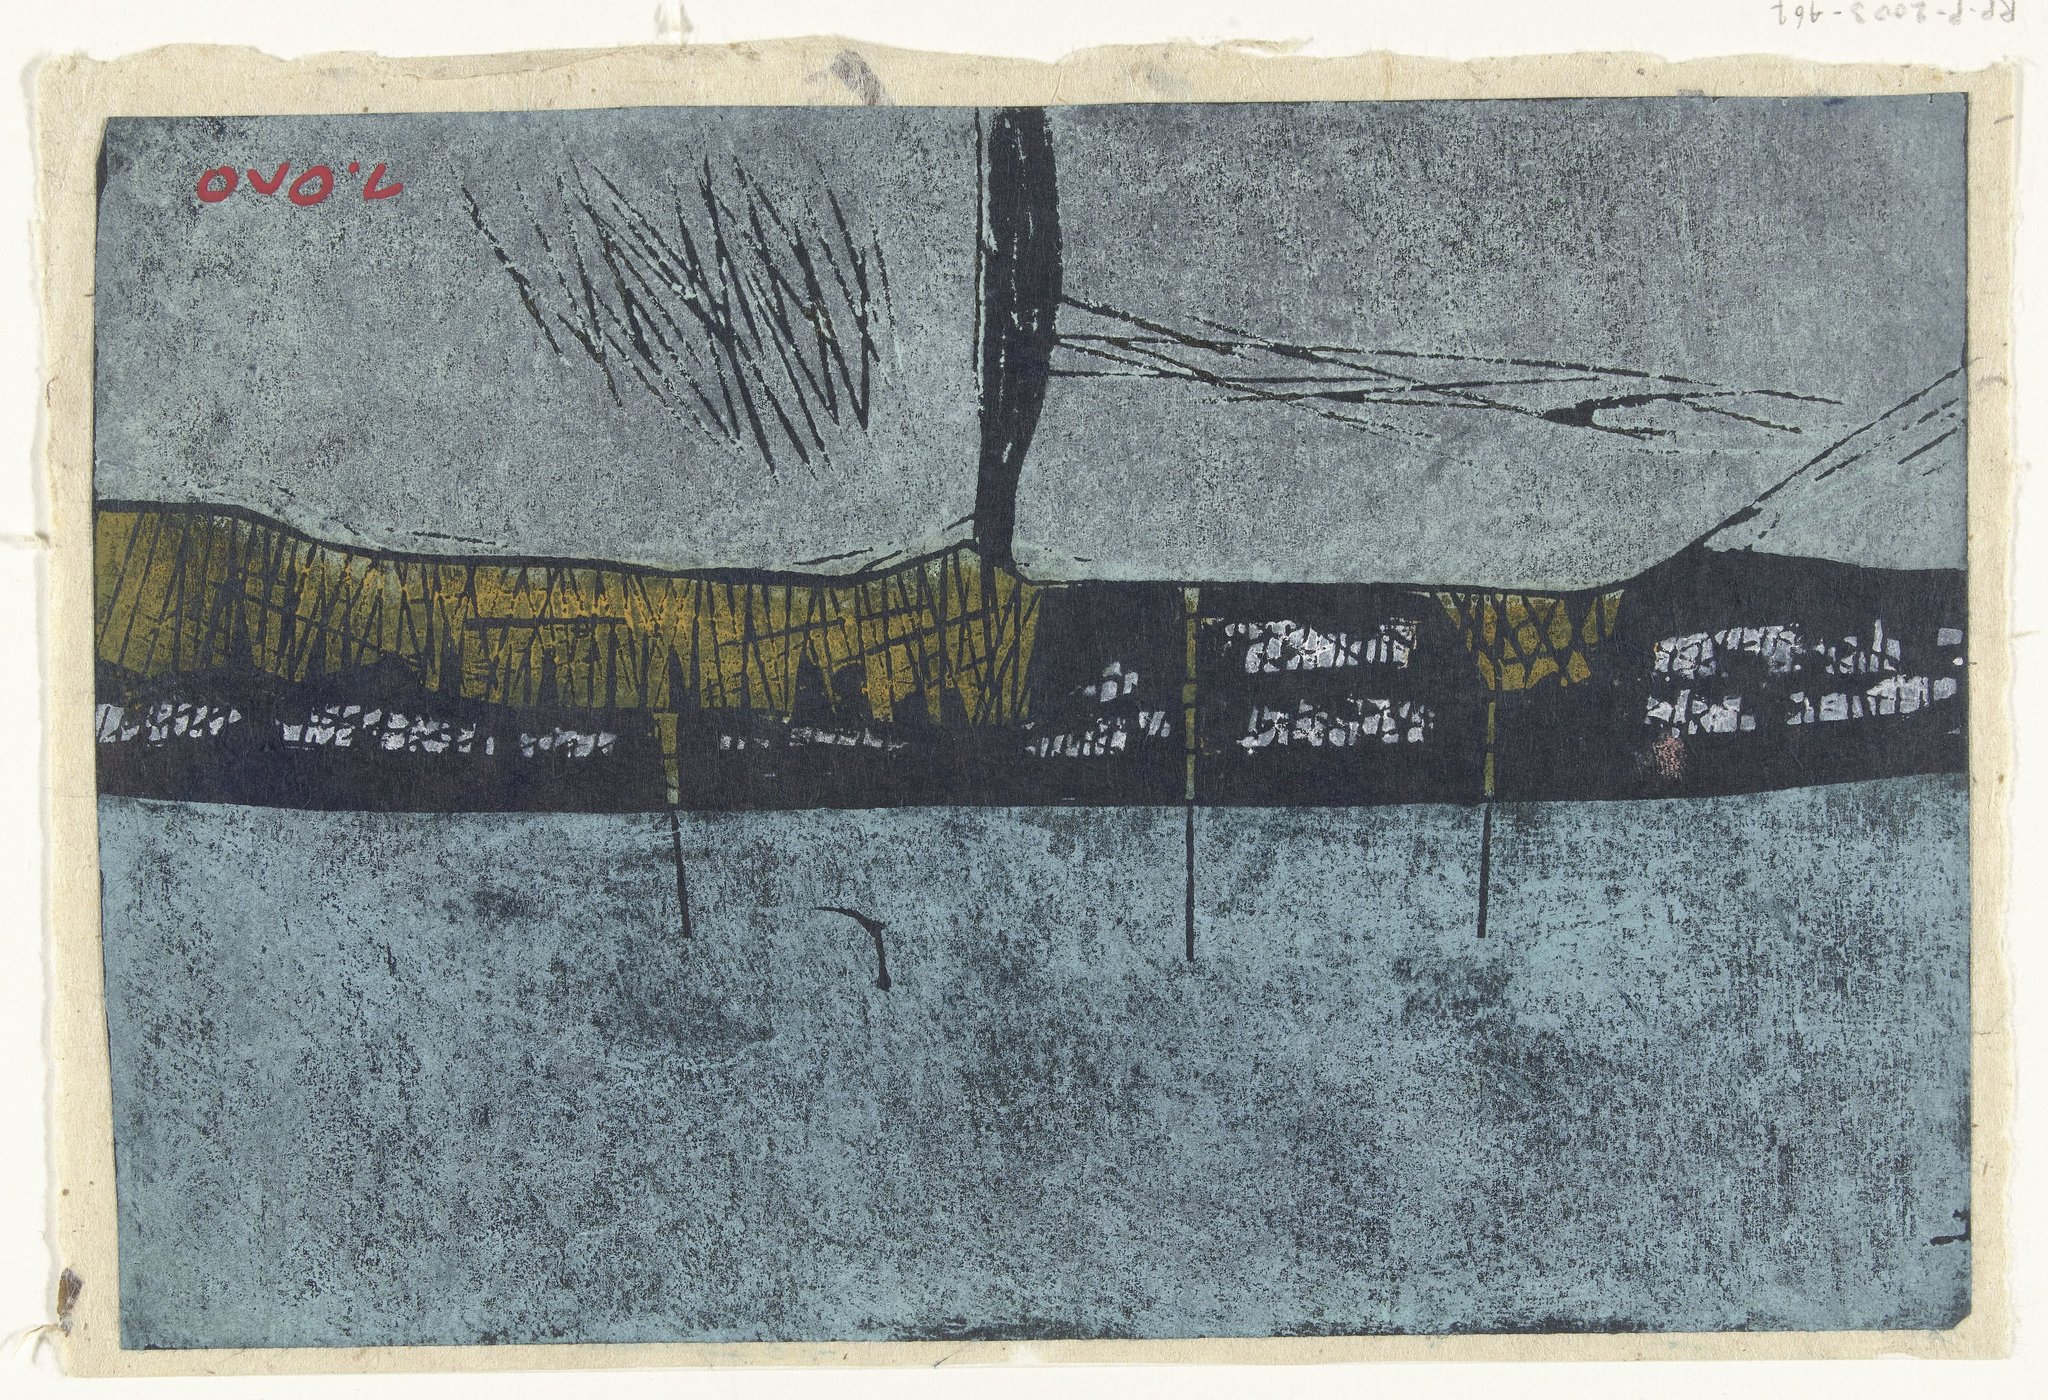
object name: print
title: Zee van het noorden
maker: ono tadashige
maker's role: print maker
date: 1974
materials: paper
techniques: woodcut, writing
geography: japan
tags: water course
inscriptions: collector's mark: Lugt 2228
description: Gestileerd landschap, gedrukt op blauw papier; bevestigd op iets groter blad Japans papier waarop op verso handgeschreven signatuur, titel en oplage.